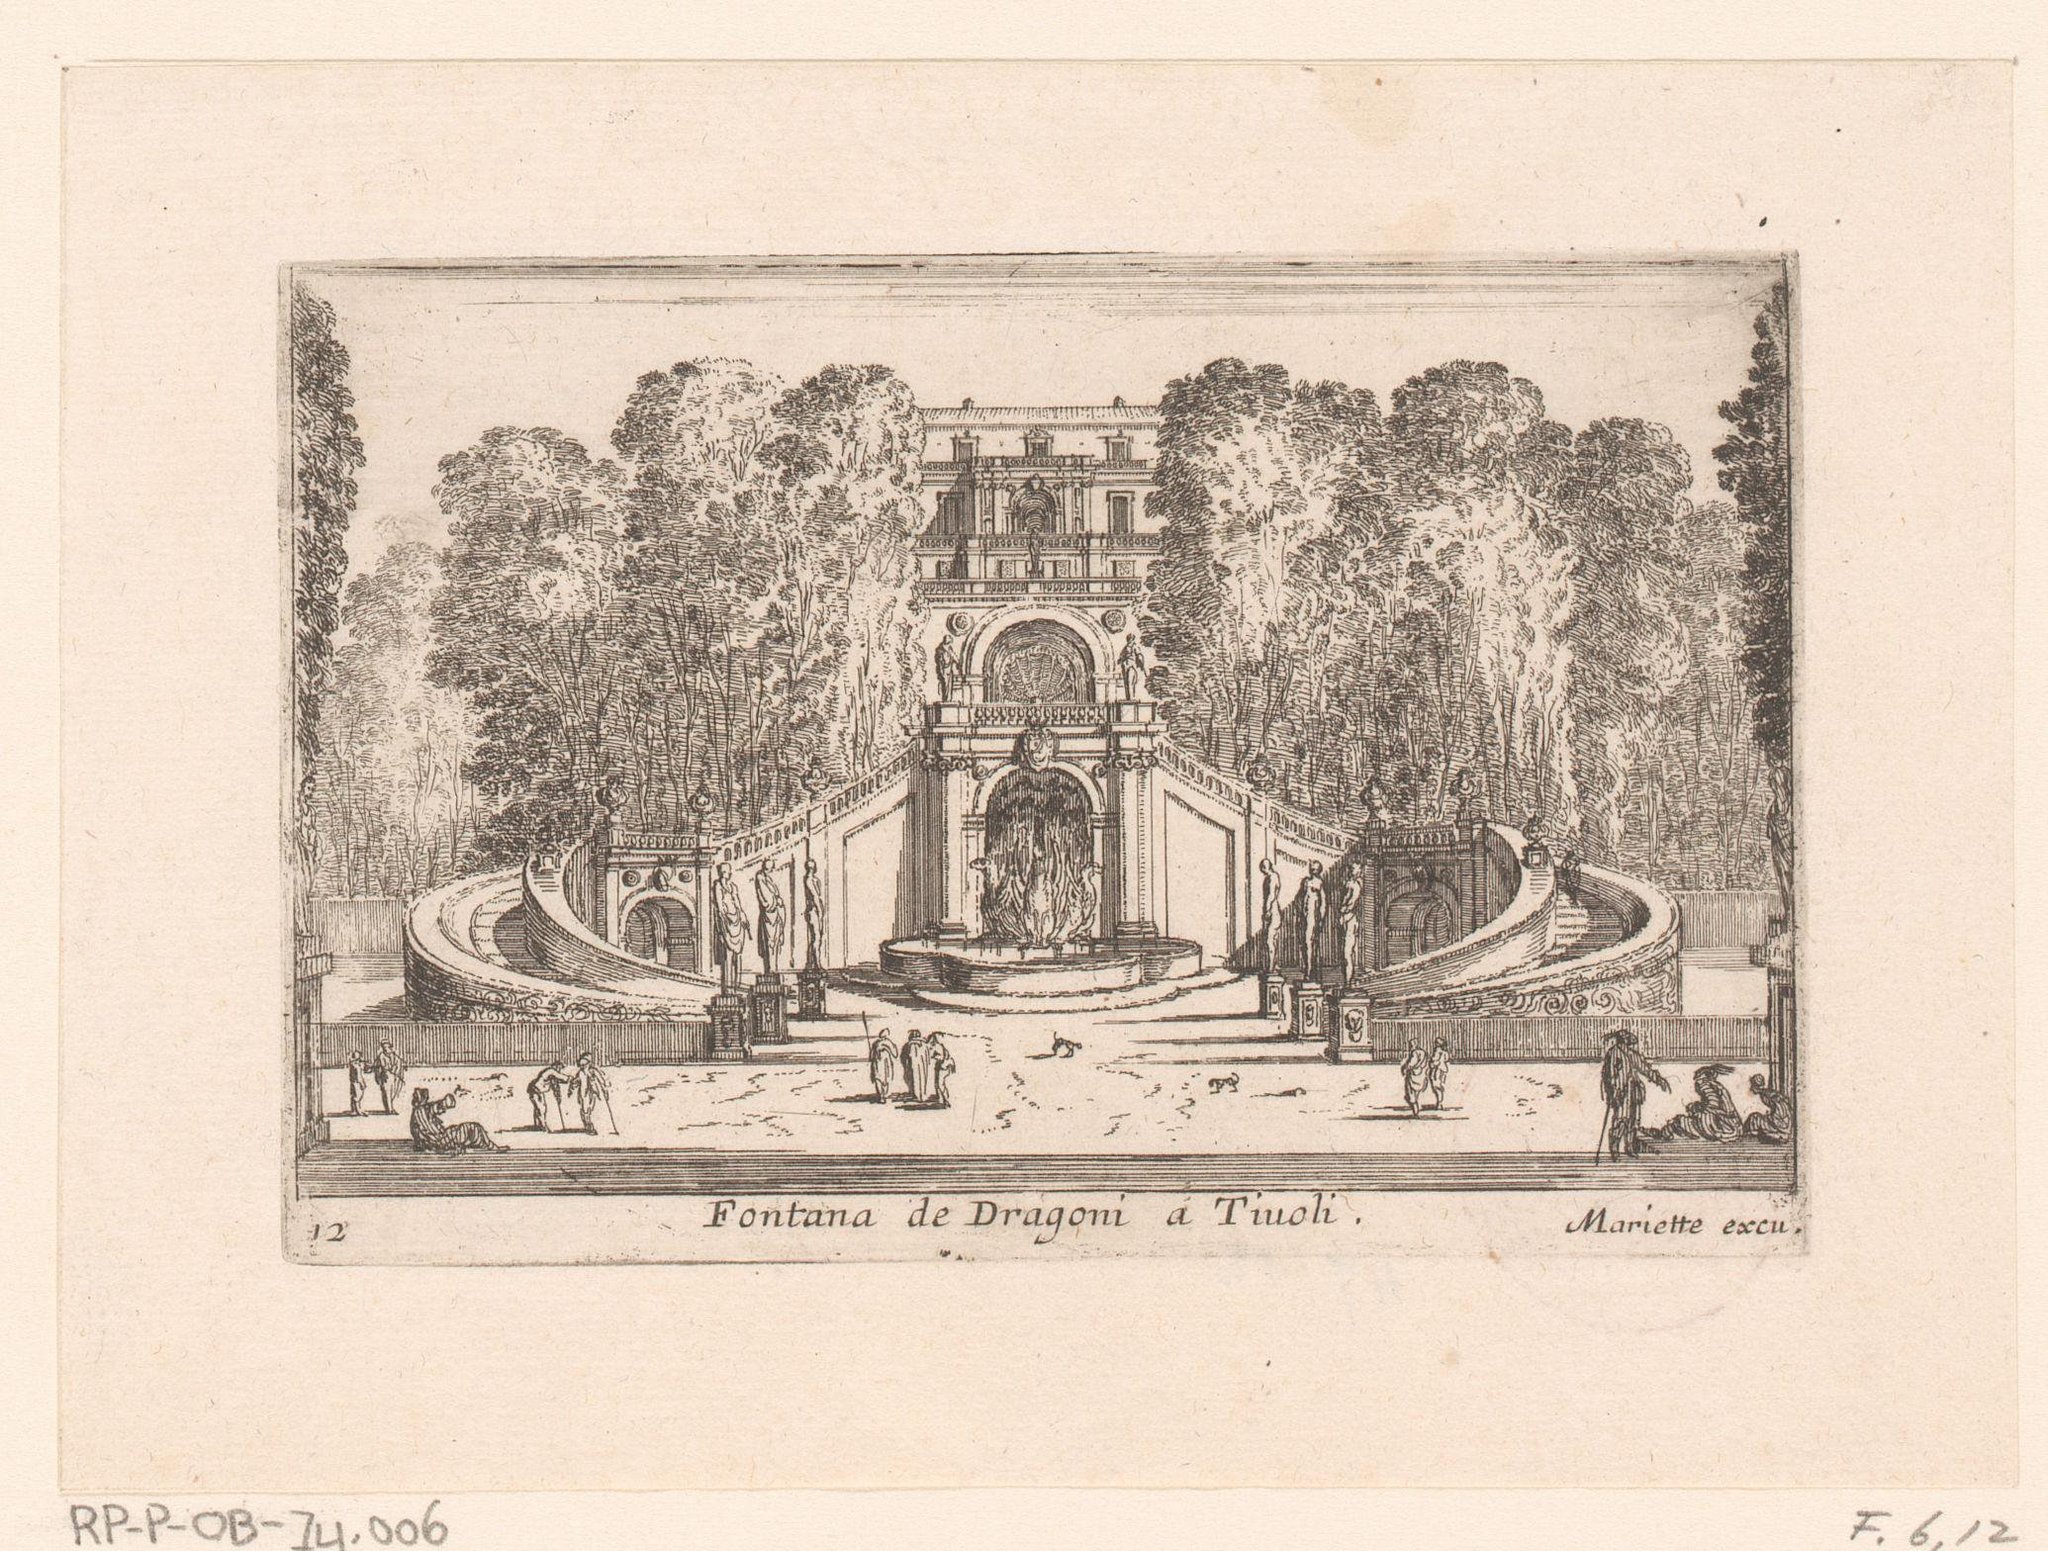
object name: print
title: Enige gezichten op tuinen en fonteinen in Rome en Tivoli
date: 1646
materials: paper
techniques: etching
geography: paris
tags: garden fountain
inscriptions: collector's mark: Lugt 240